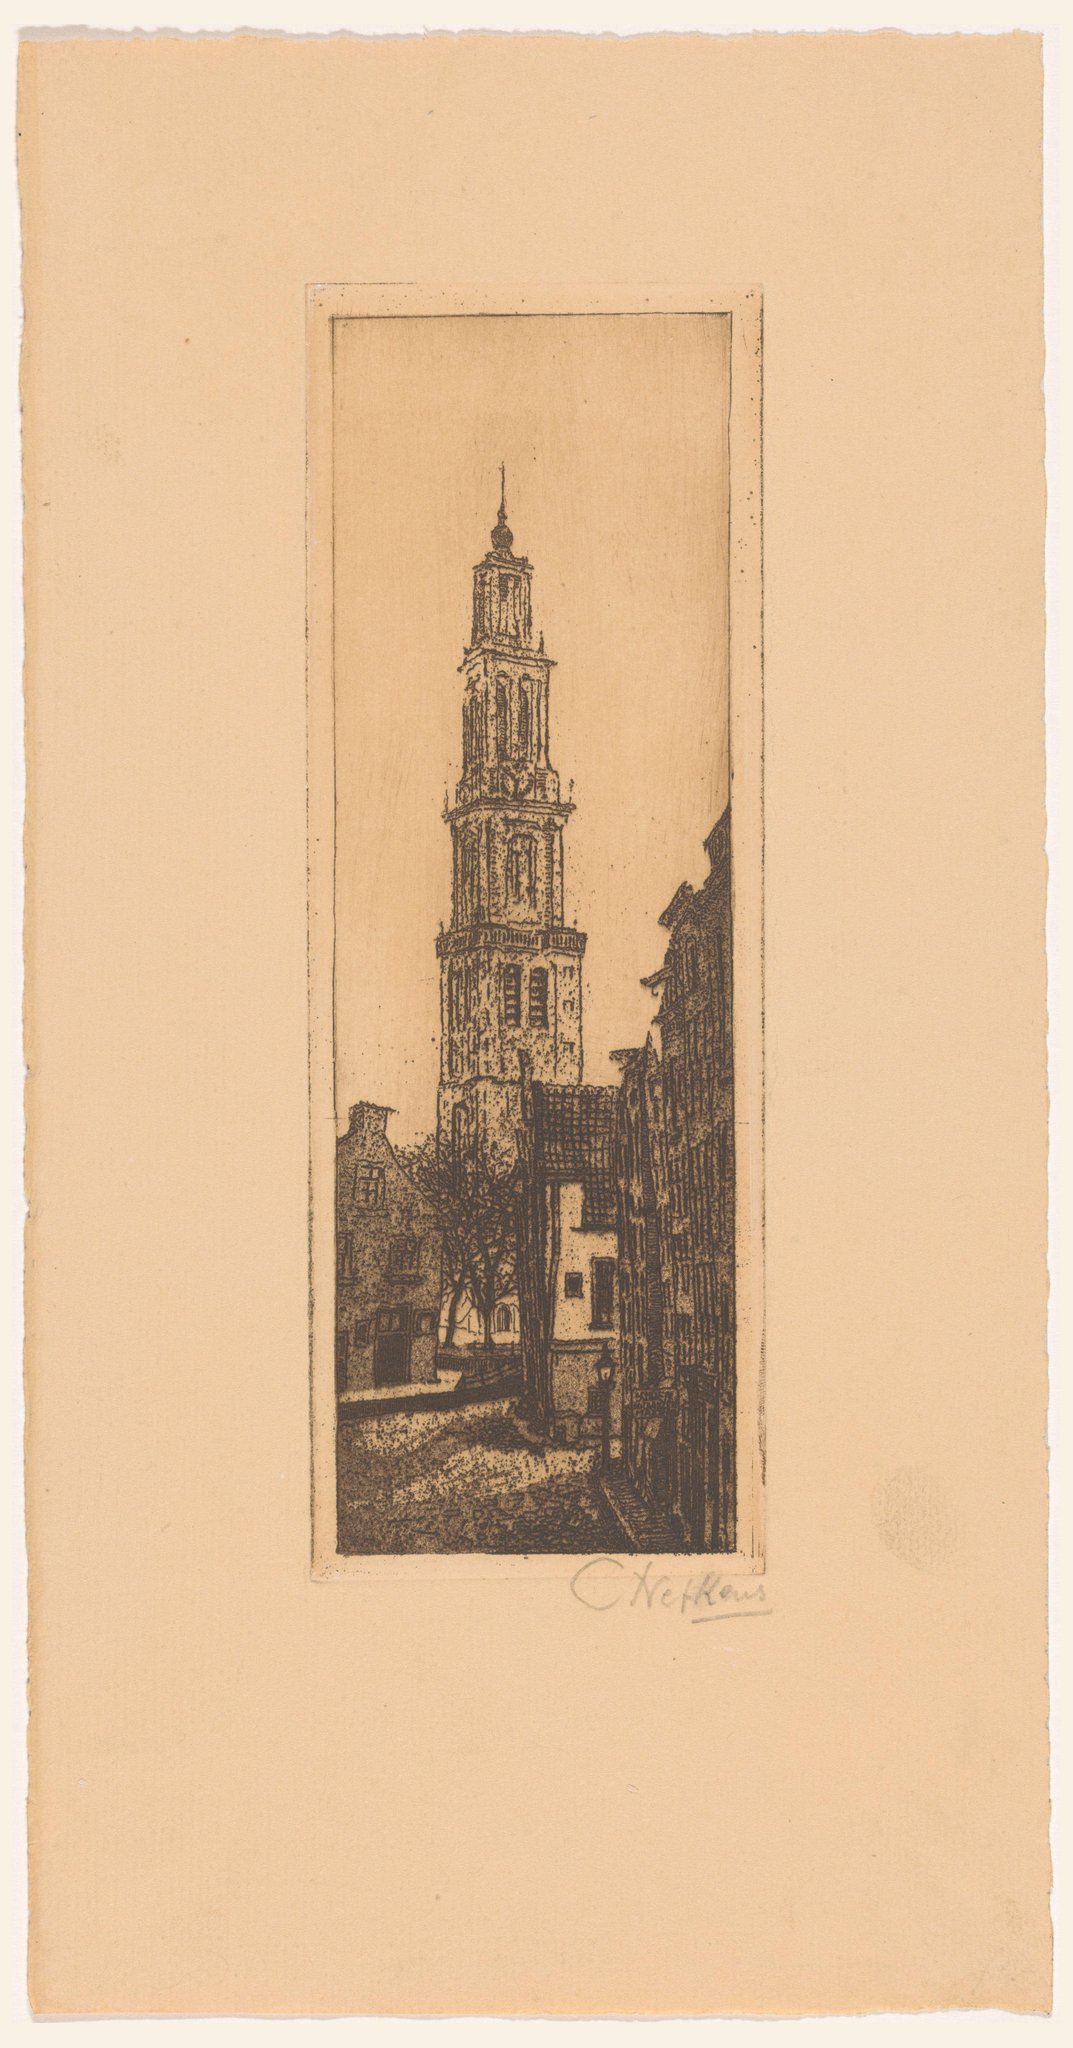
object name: print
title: Straatgezicht met kerktoren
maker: constant nefkens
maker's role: print maker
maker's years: 1887-1929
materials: paper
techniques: aquatint, etching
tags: parts of church exterior and annexes: tower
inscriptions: collector's mark: Lugt 2760, collector's mark: Lugt 2228